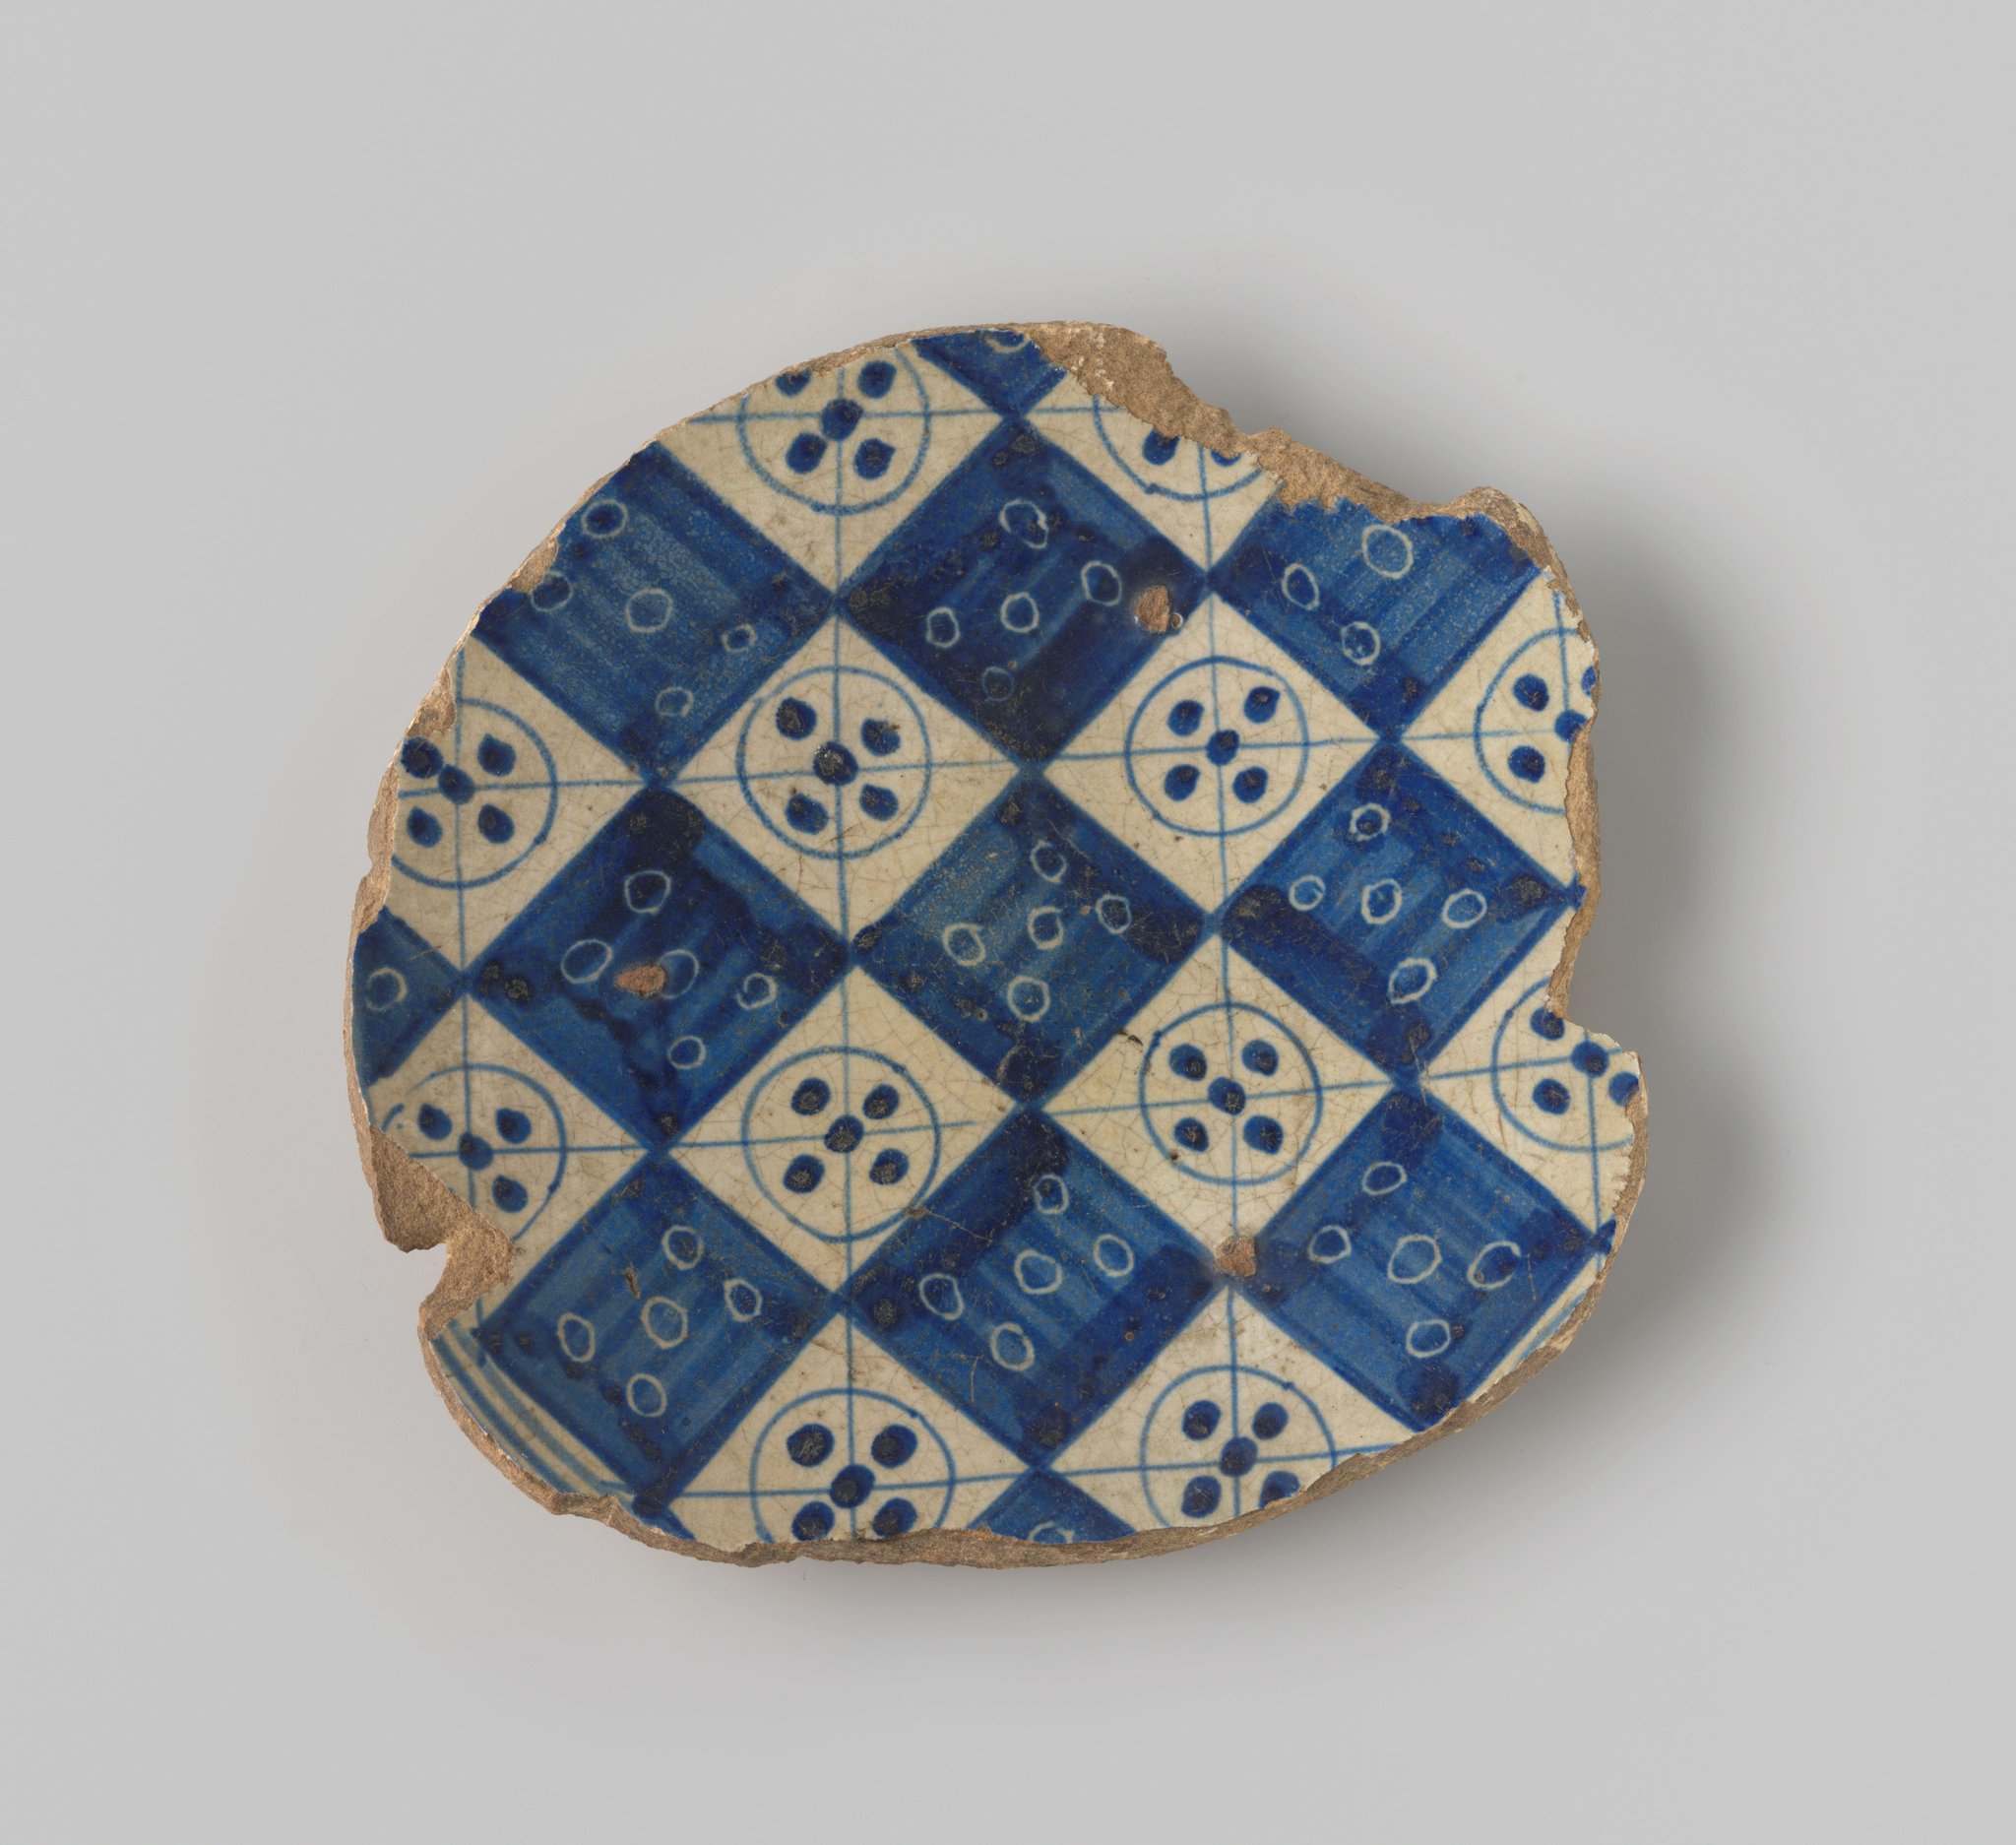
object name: platter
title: Fragment in de vorm van een bodem van een schotel, beschilderd met schaakbordmotief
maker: Anonymous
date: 1600-1650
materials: earthenware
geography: north holland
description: Fragment in de vorm van een bodem van een schotel, beschilderd in blauw met een schaakbordmotief: op de witte vakken een cirkel met vijf punten; op de blauwe vakken vijf cirkels, uitgespaard in de fond.